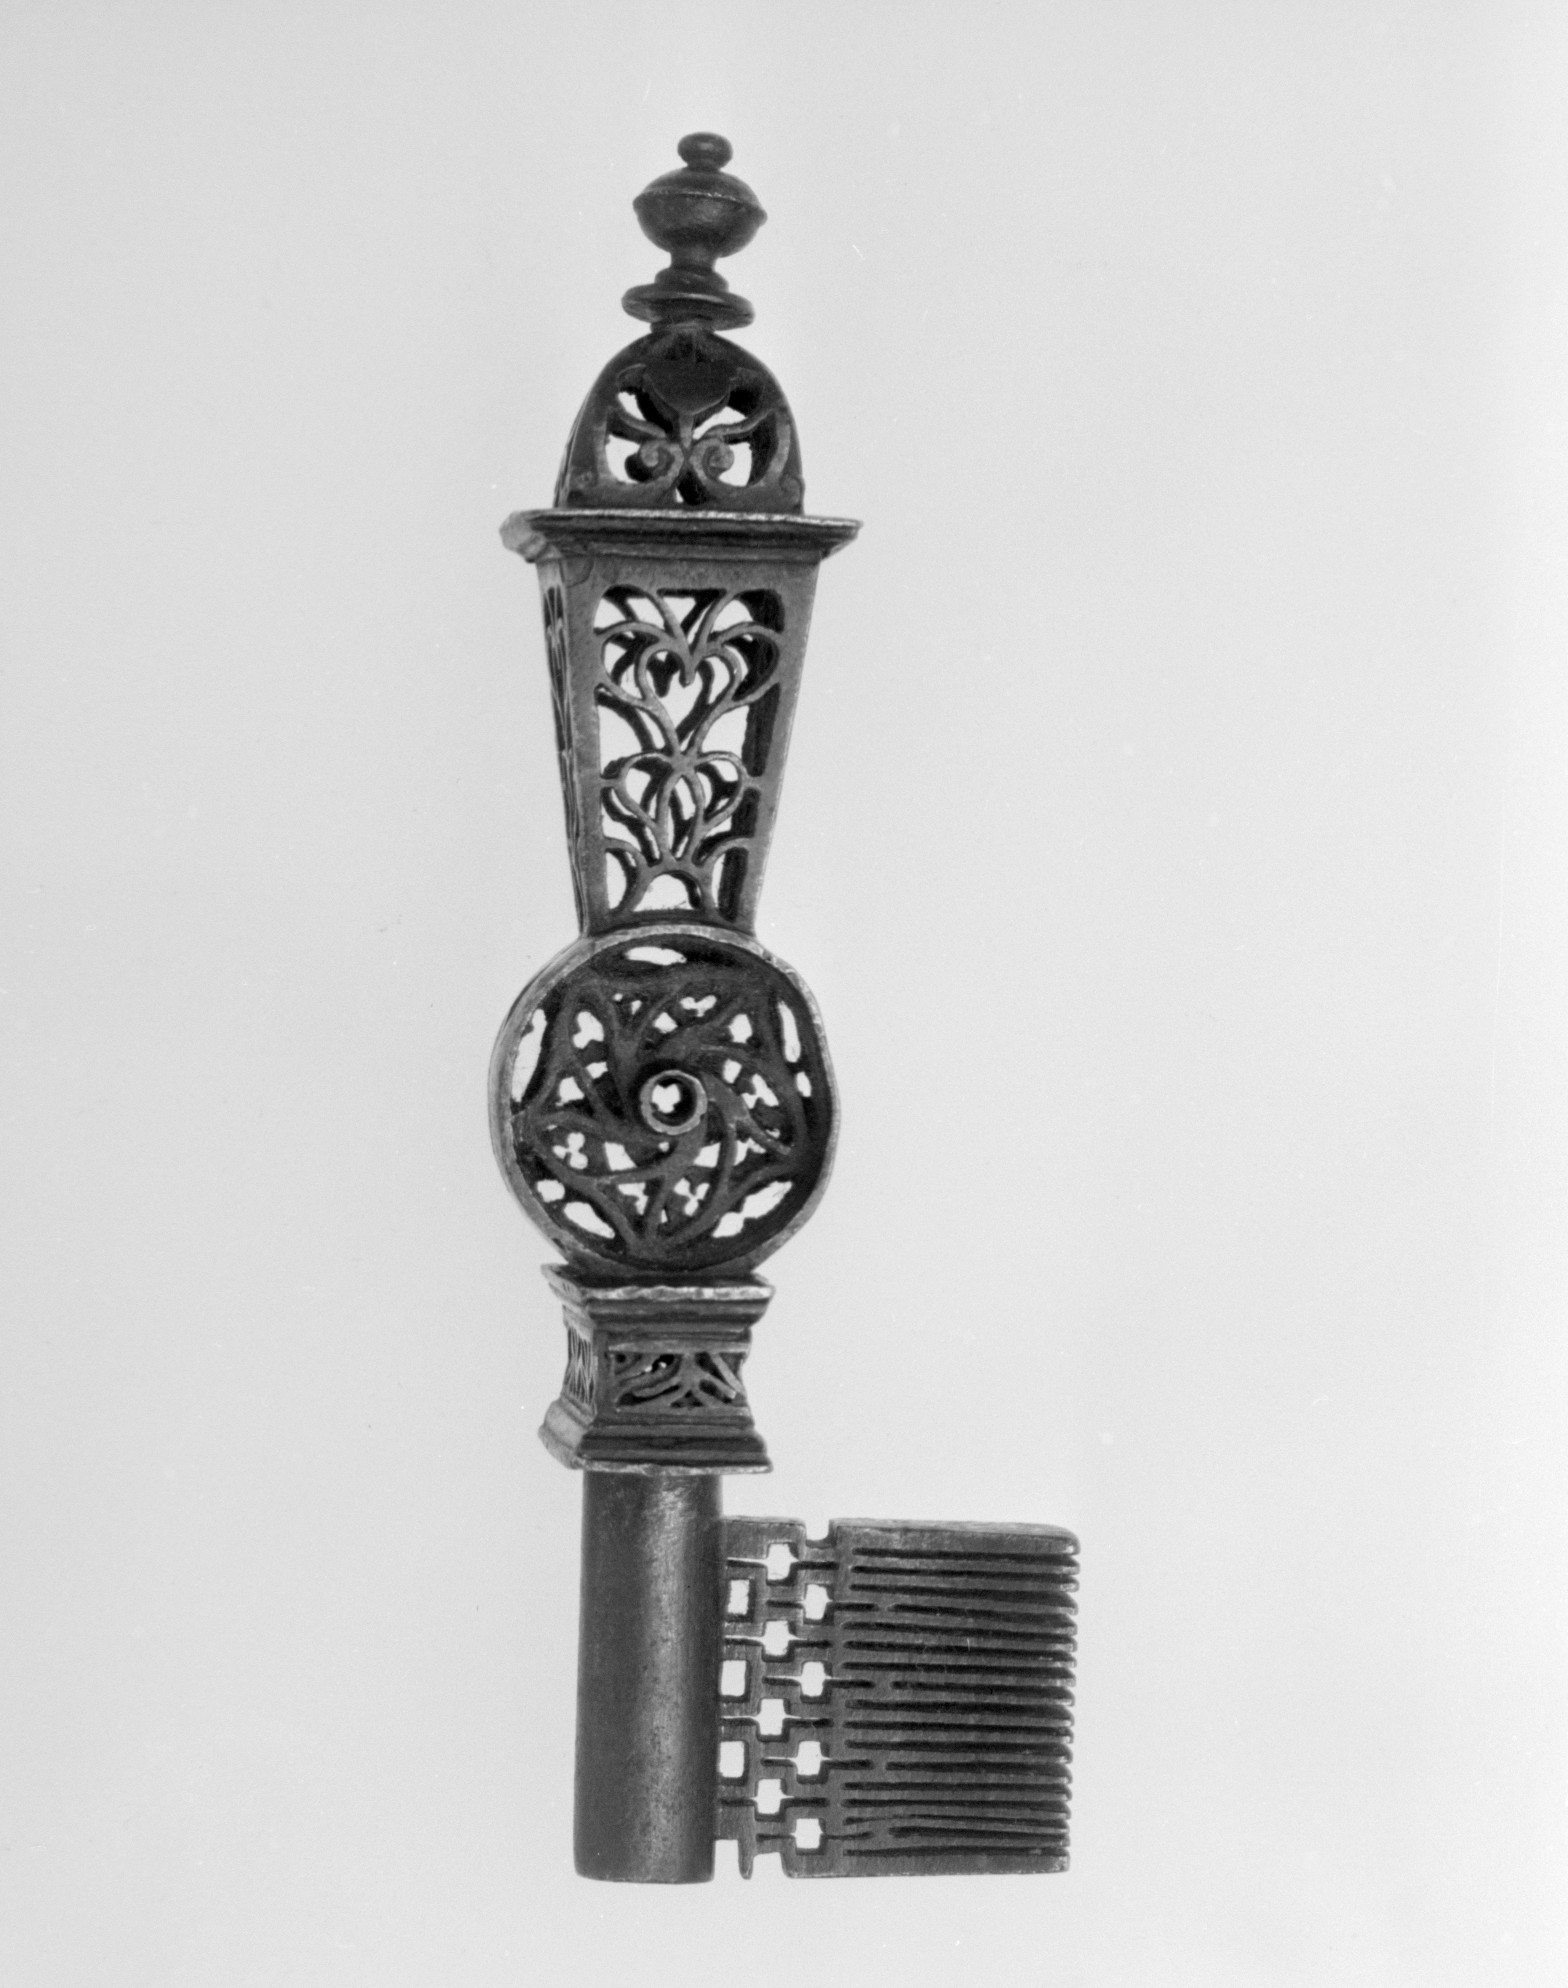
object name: key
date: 1501-1600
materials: steel